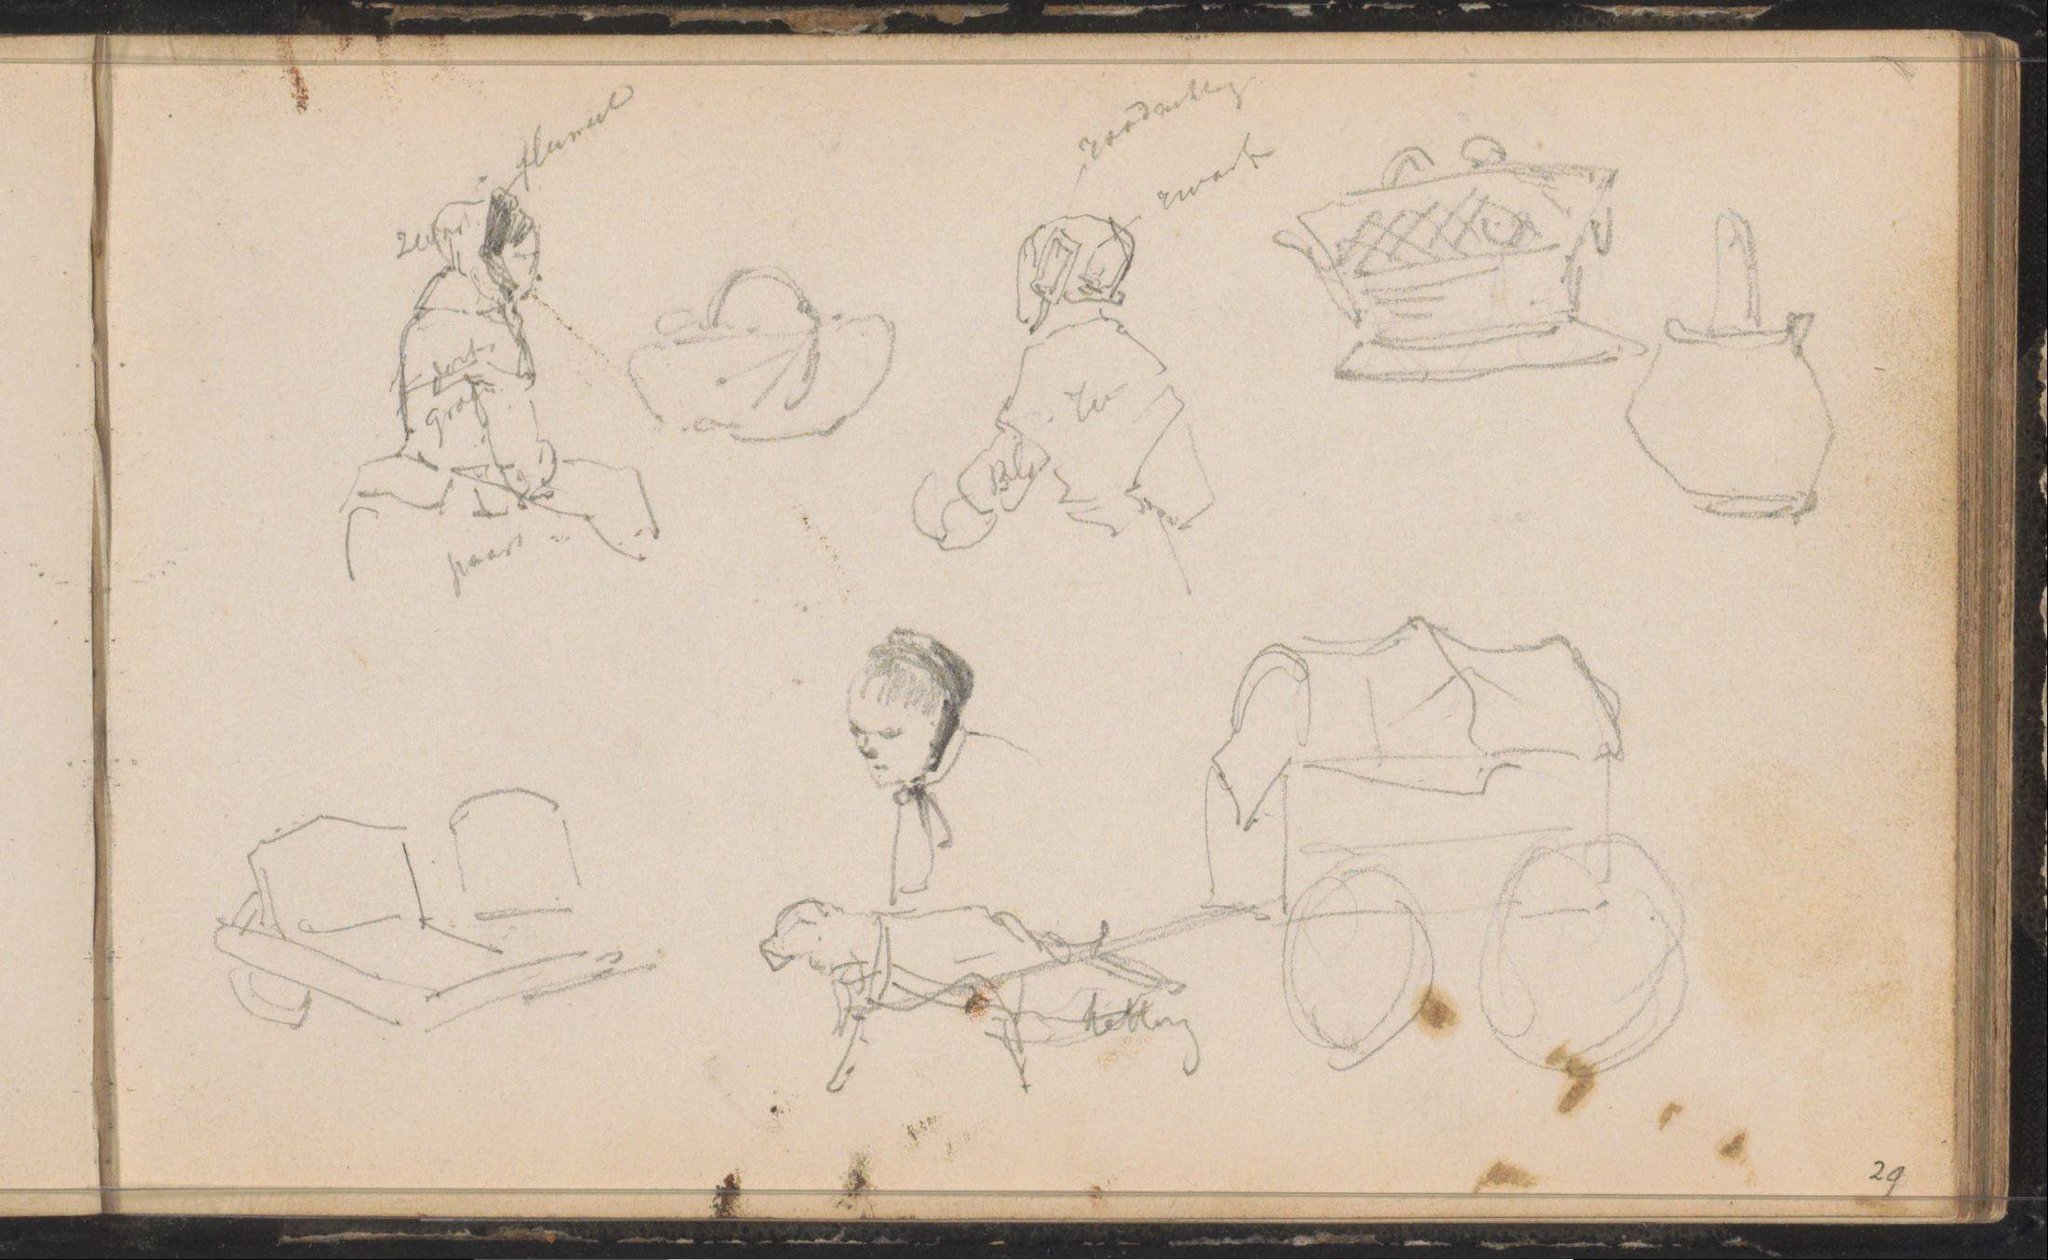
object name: sketchbook leaf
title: Figuren, karren en manden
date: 1863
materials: paper, pencil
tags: hand-cart, adult woman, head-gear, container made of plant material other than wood: basket, dog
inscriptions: kleurnotitie, handgeschreven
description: Vrouwen met mutsen. Verder manden en twee karren, waarvan één met een hond ervoor. Blad 29 uit een schetsboek met 55 bladen vervaardigd op de Veluwe en in Noord-Duitsland.